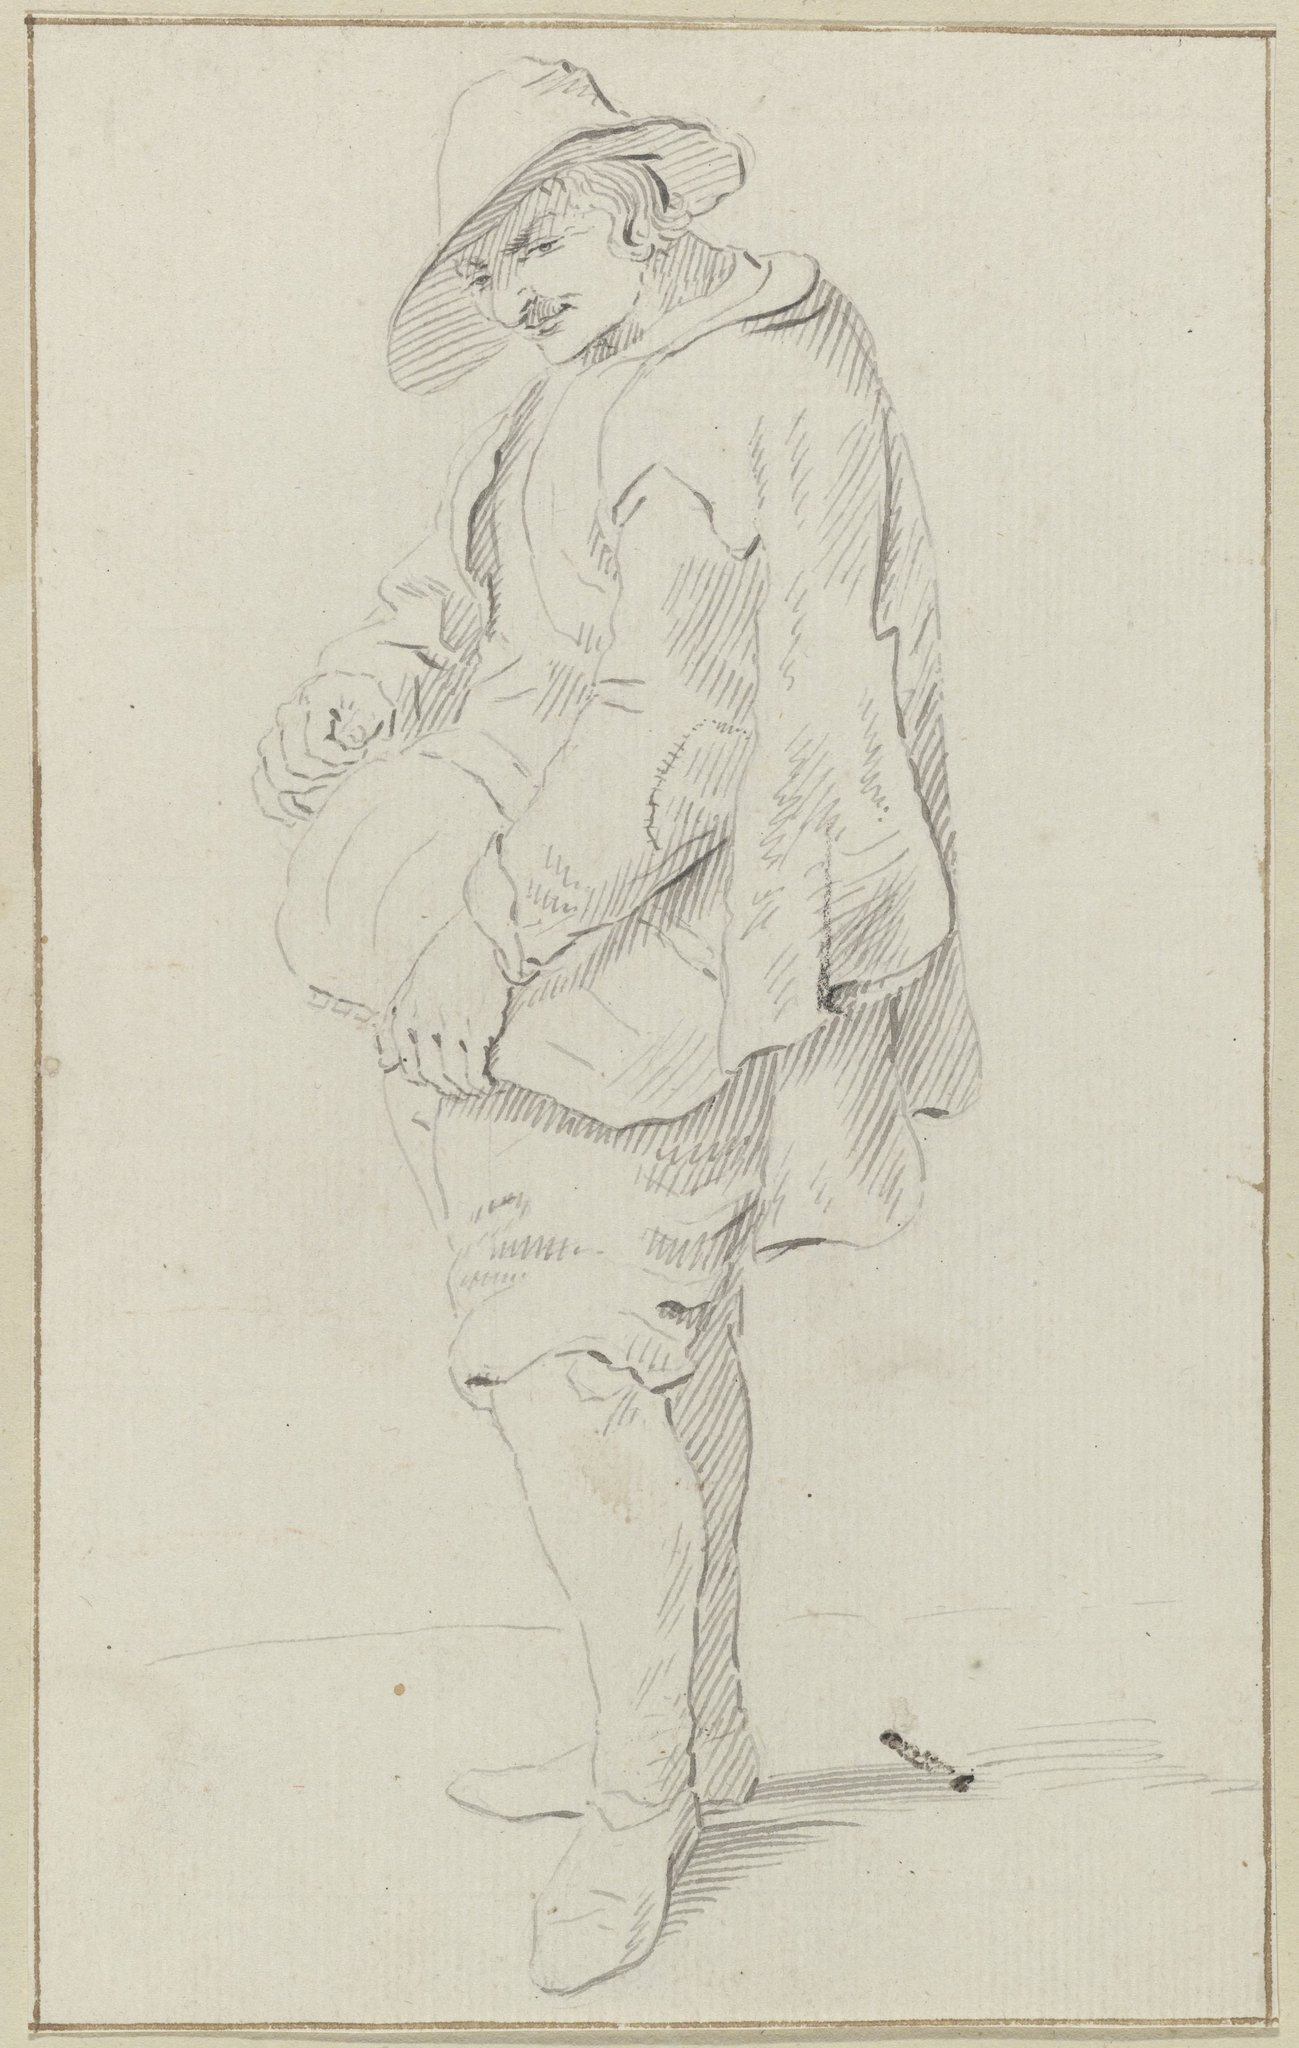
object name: drawing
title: Staande man met hoed een draailier bespelend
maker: Anonymous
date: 1700-1799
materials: ink, paper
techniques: pen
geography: netherlands